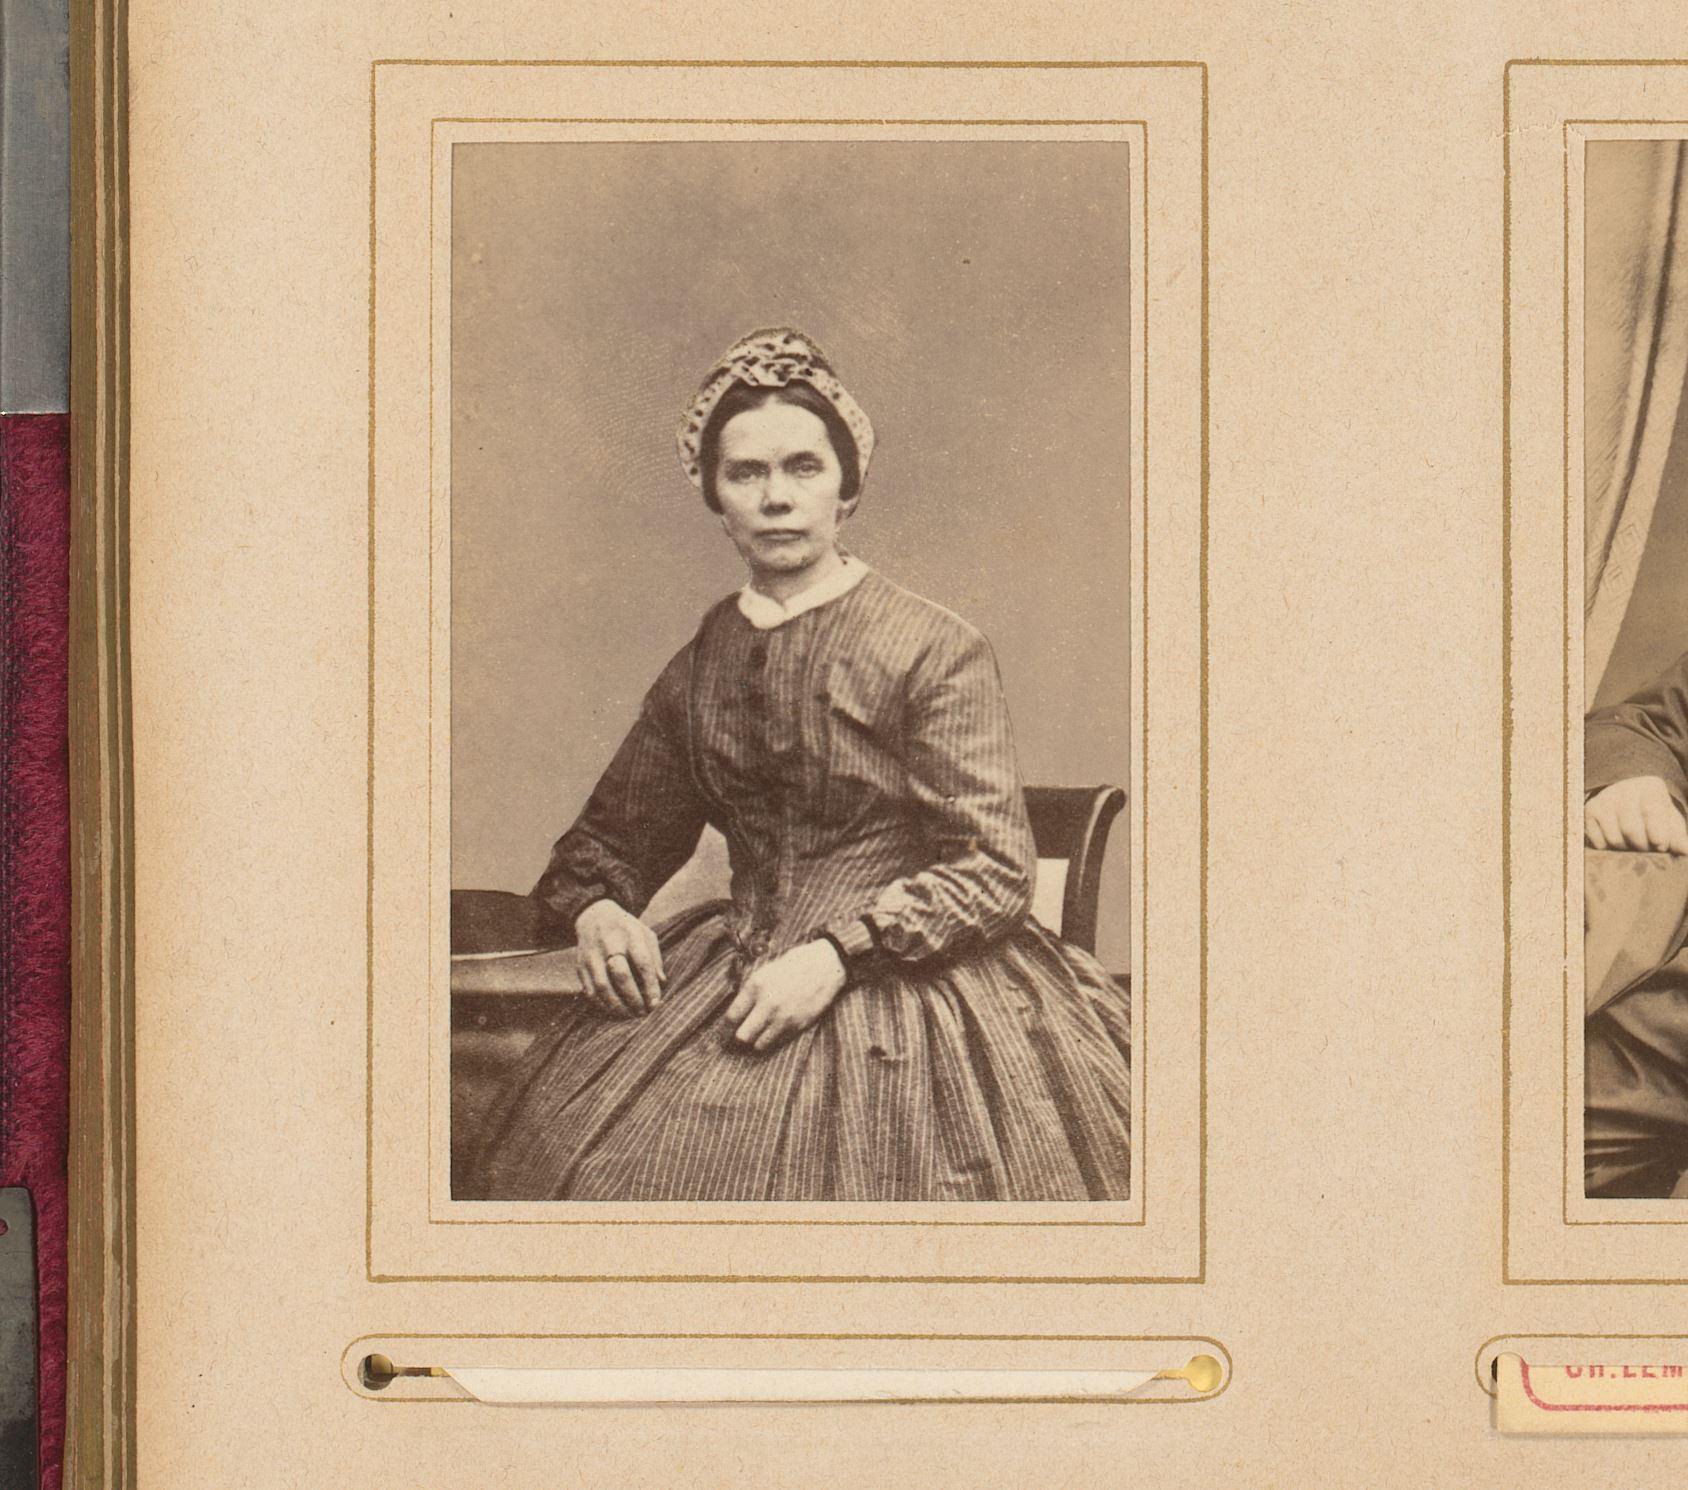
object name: album leaf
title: Portret van een zittende vrouw met muts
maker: emanuel lorjé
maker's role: fotograaf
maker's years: 1845-1875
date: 1869-1875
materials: cardboard, photographic support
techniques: albumen print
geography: netherlands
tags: historical persons - bb - woman, head-gear: cap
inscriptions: inscription: ‘E. Lorje. Phot’